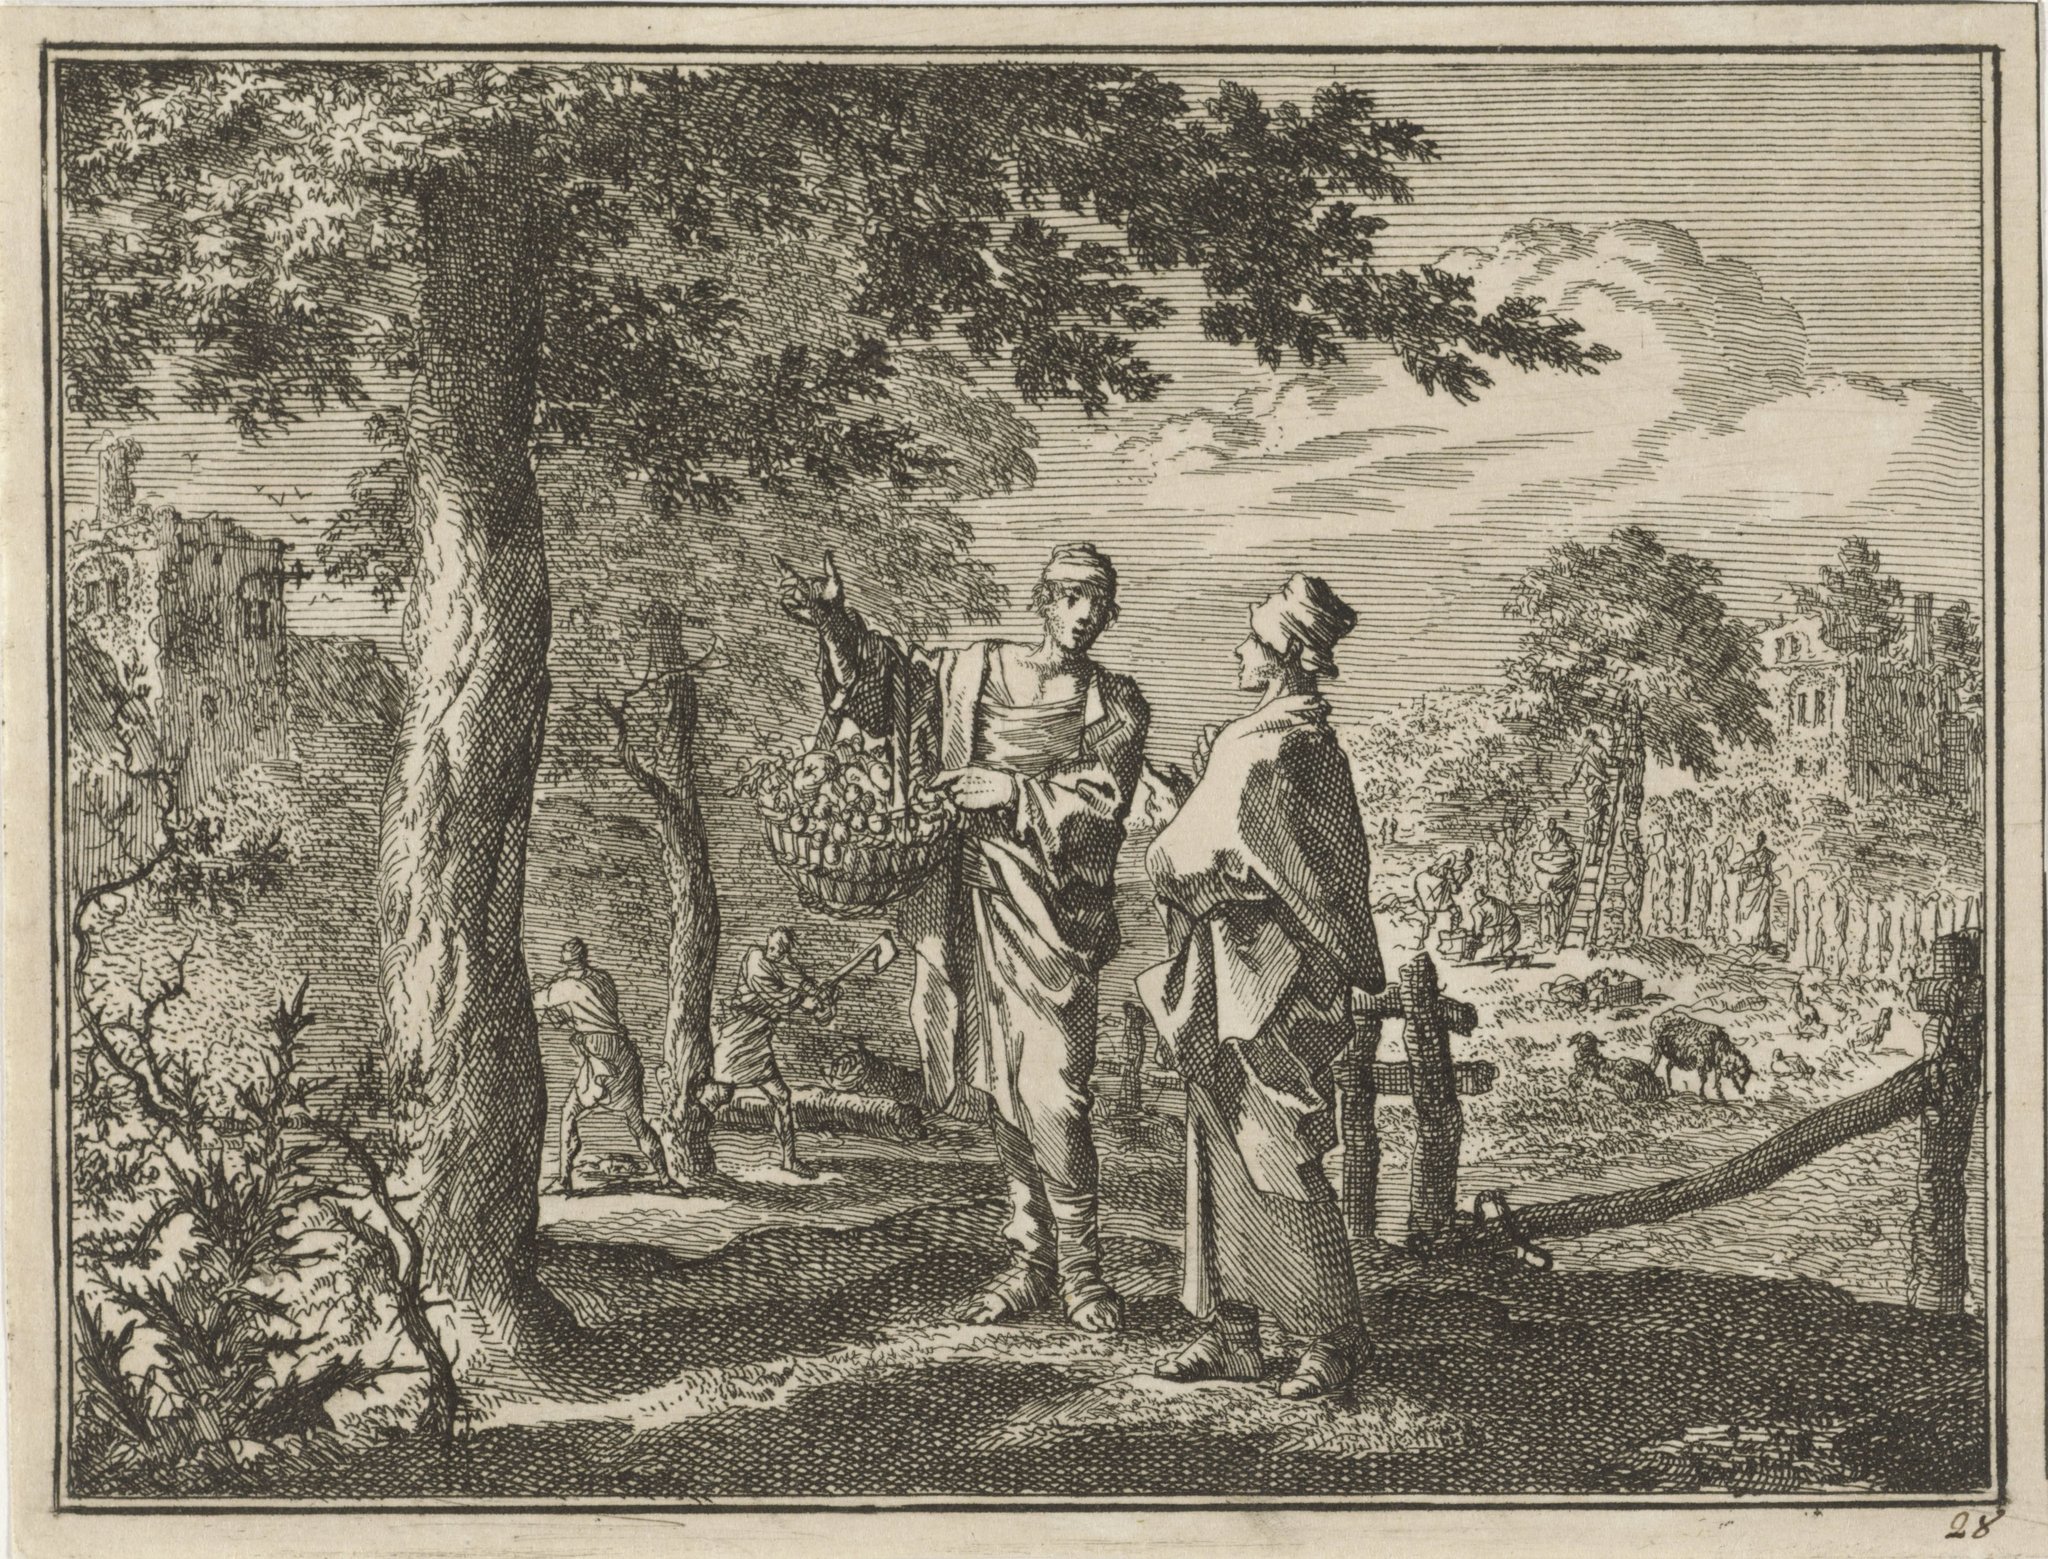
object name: print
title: Mannen zoeken bij een boom naar vruchten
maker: jan luyken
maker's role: draughtsman, print maker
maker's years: 1649-1712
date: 1712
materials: paper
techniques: etching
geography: amsterdam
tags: good tree bears good fruit; corrupt tree bears evil fruit ~ proverbial saying of christ (matthew 7:17-18, 12:33; luke 6:43)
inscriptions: number: ‘28’, collector's mark: Lugt 2228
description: Proefdruk van illustratie uit: Luyken, Jan. De schriftuurlyke geschiedenissen en gelykenissen van het Oude en Nieuwe Verbond, 2 delen. Amsterdam: Wed. Pieter Arentsz II en Cornelis van der Sys, 1712, dl. II.